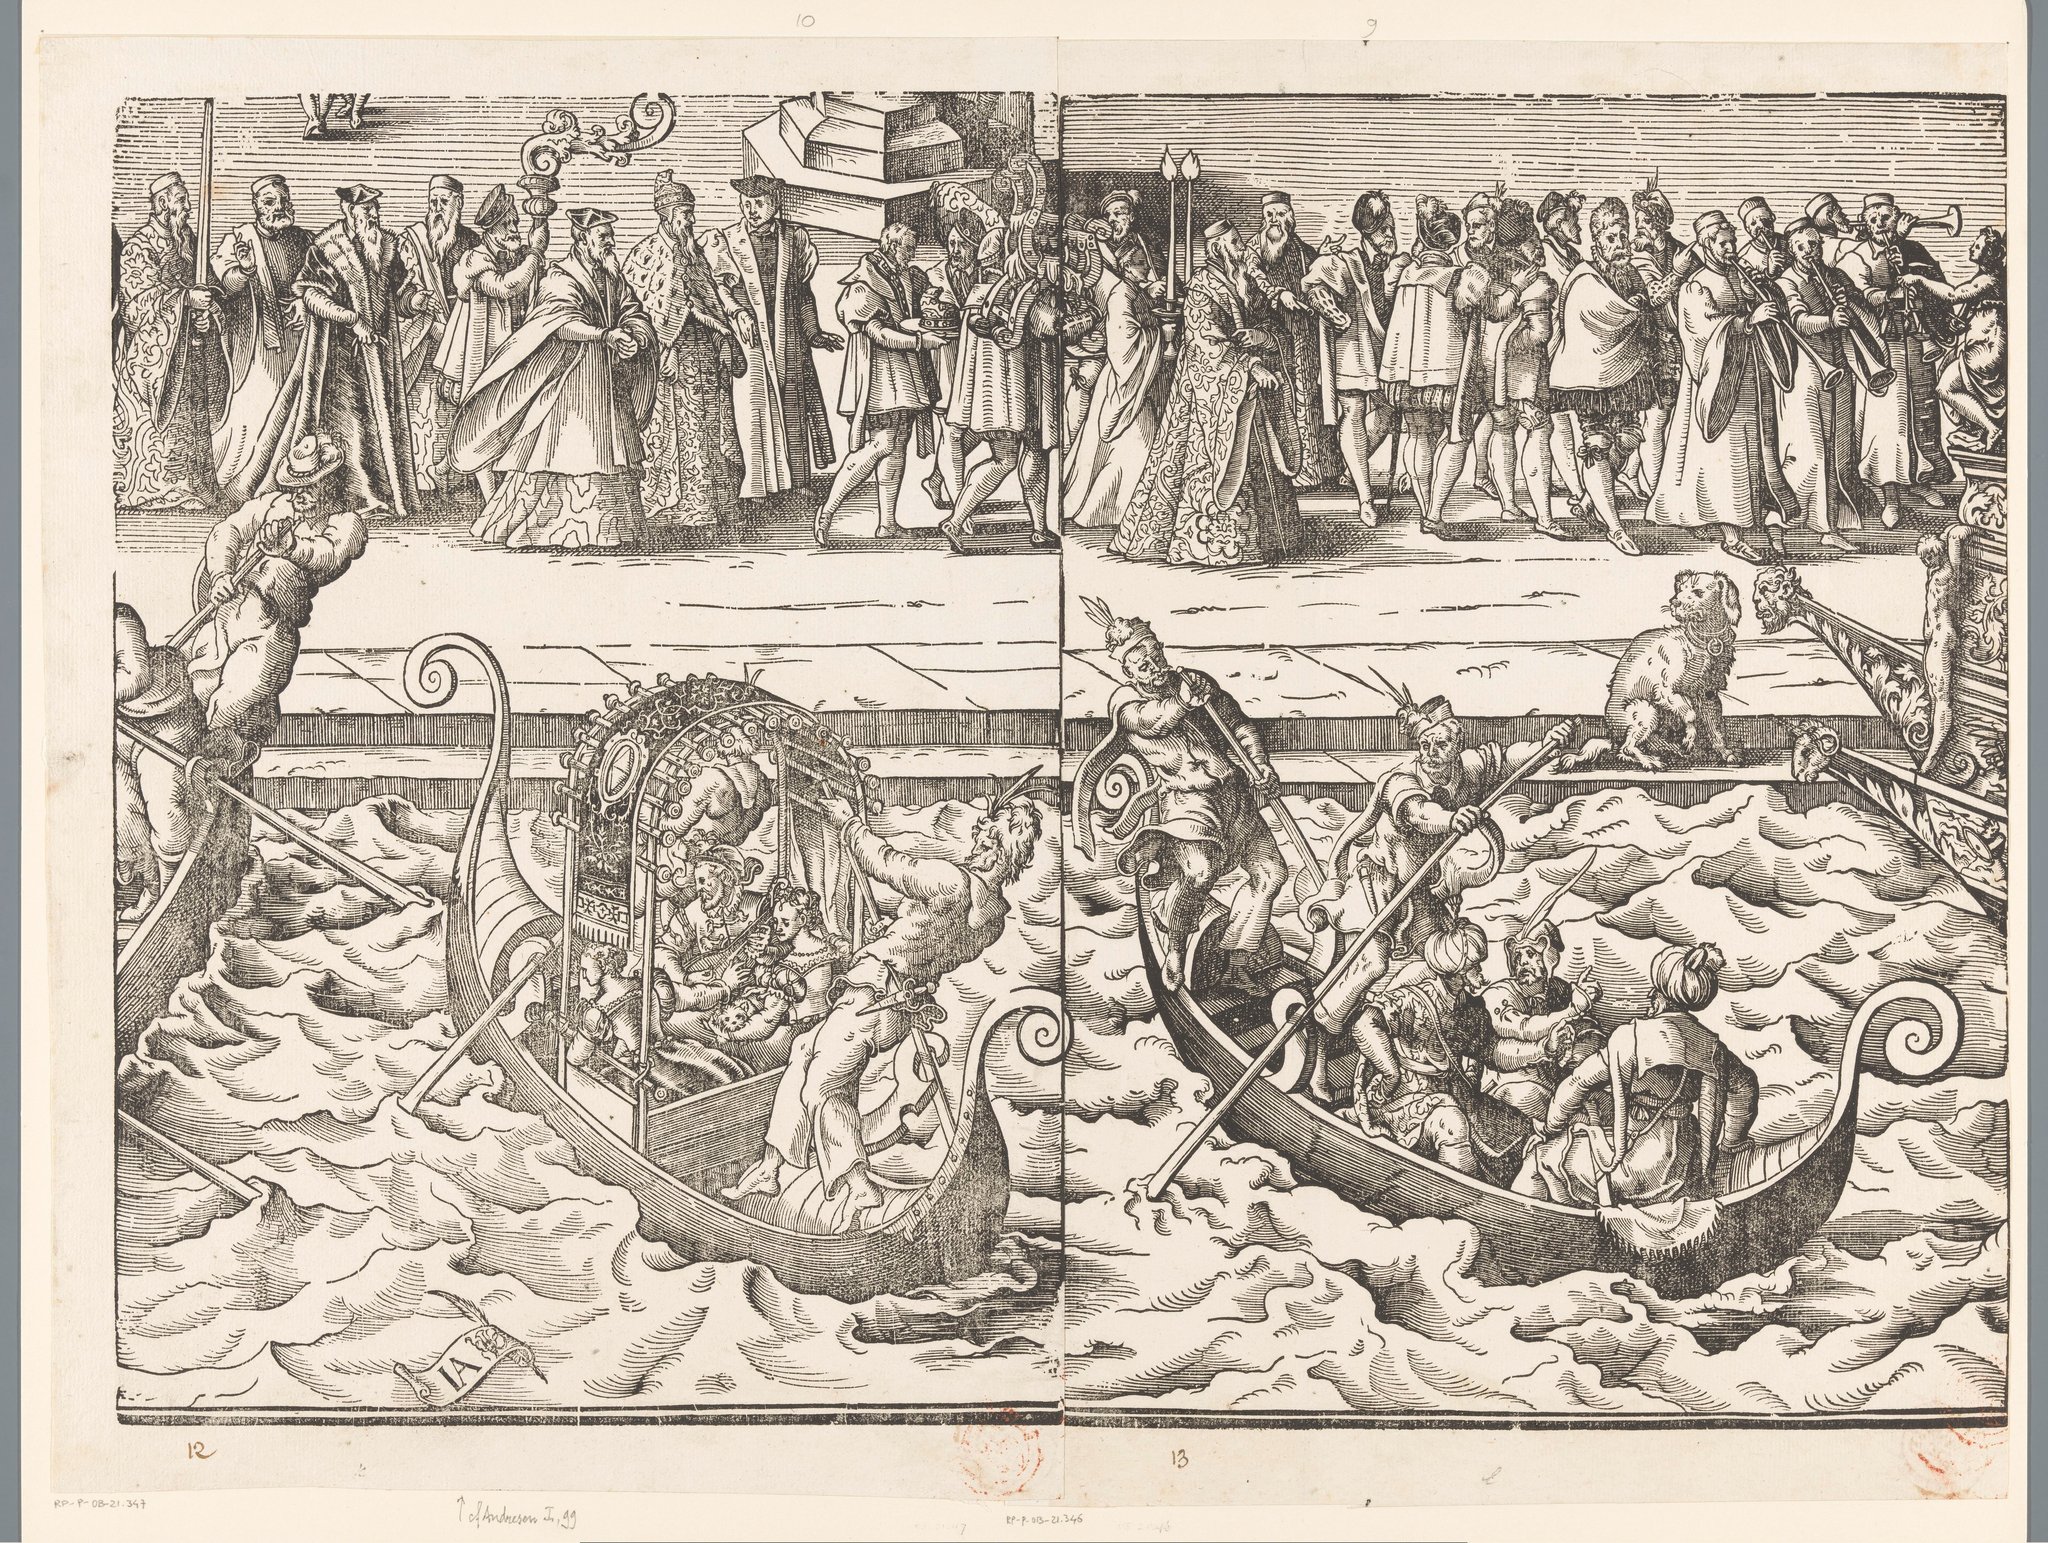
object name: print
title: Ankunfft Und herkommen der weitberümbten herrlichen Statt Venedig Sambt derselben gewaltigen Herrschafft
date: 1679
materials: paper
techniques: woodcut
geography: nuremberg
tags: city-view in general; 'veduta', wind instruments - cc - out of doors, procession ~ christian religion, gondola, dog, venice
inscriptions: number: ‘13’, collector's mark: Lugt 240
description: Negende gedeelte van een grote voorstelling van de Festa della Sensa. De voorstelling is gedrukt van veertien blokken, de titel van vijf blokken en het onderschrift bestaat uit vijf delen van elk drie kolommen Duits tekst. De veertien blokken die samen de voorstelling vormen zijn in de titels met de klok mee vanaf linksboven genummerd. In de collectie Rijksmuseum bevinden zich twee complete exemplaren inclusief titel en onderschrift. Omdat niet alle delen van de titel en het onderschrift op afzonderlijke bladen zijn gedrukt, is dit exemplaar niet virtueel samengevoegd omwille van een betere presentatie. Zie voor het andere exemplaar: RP-P-2017-6073.